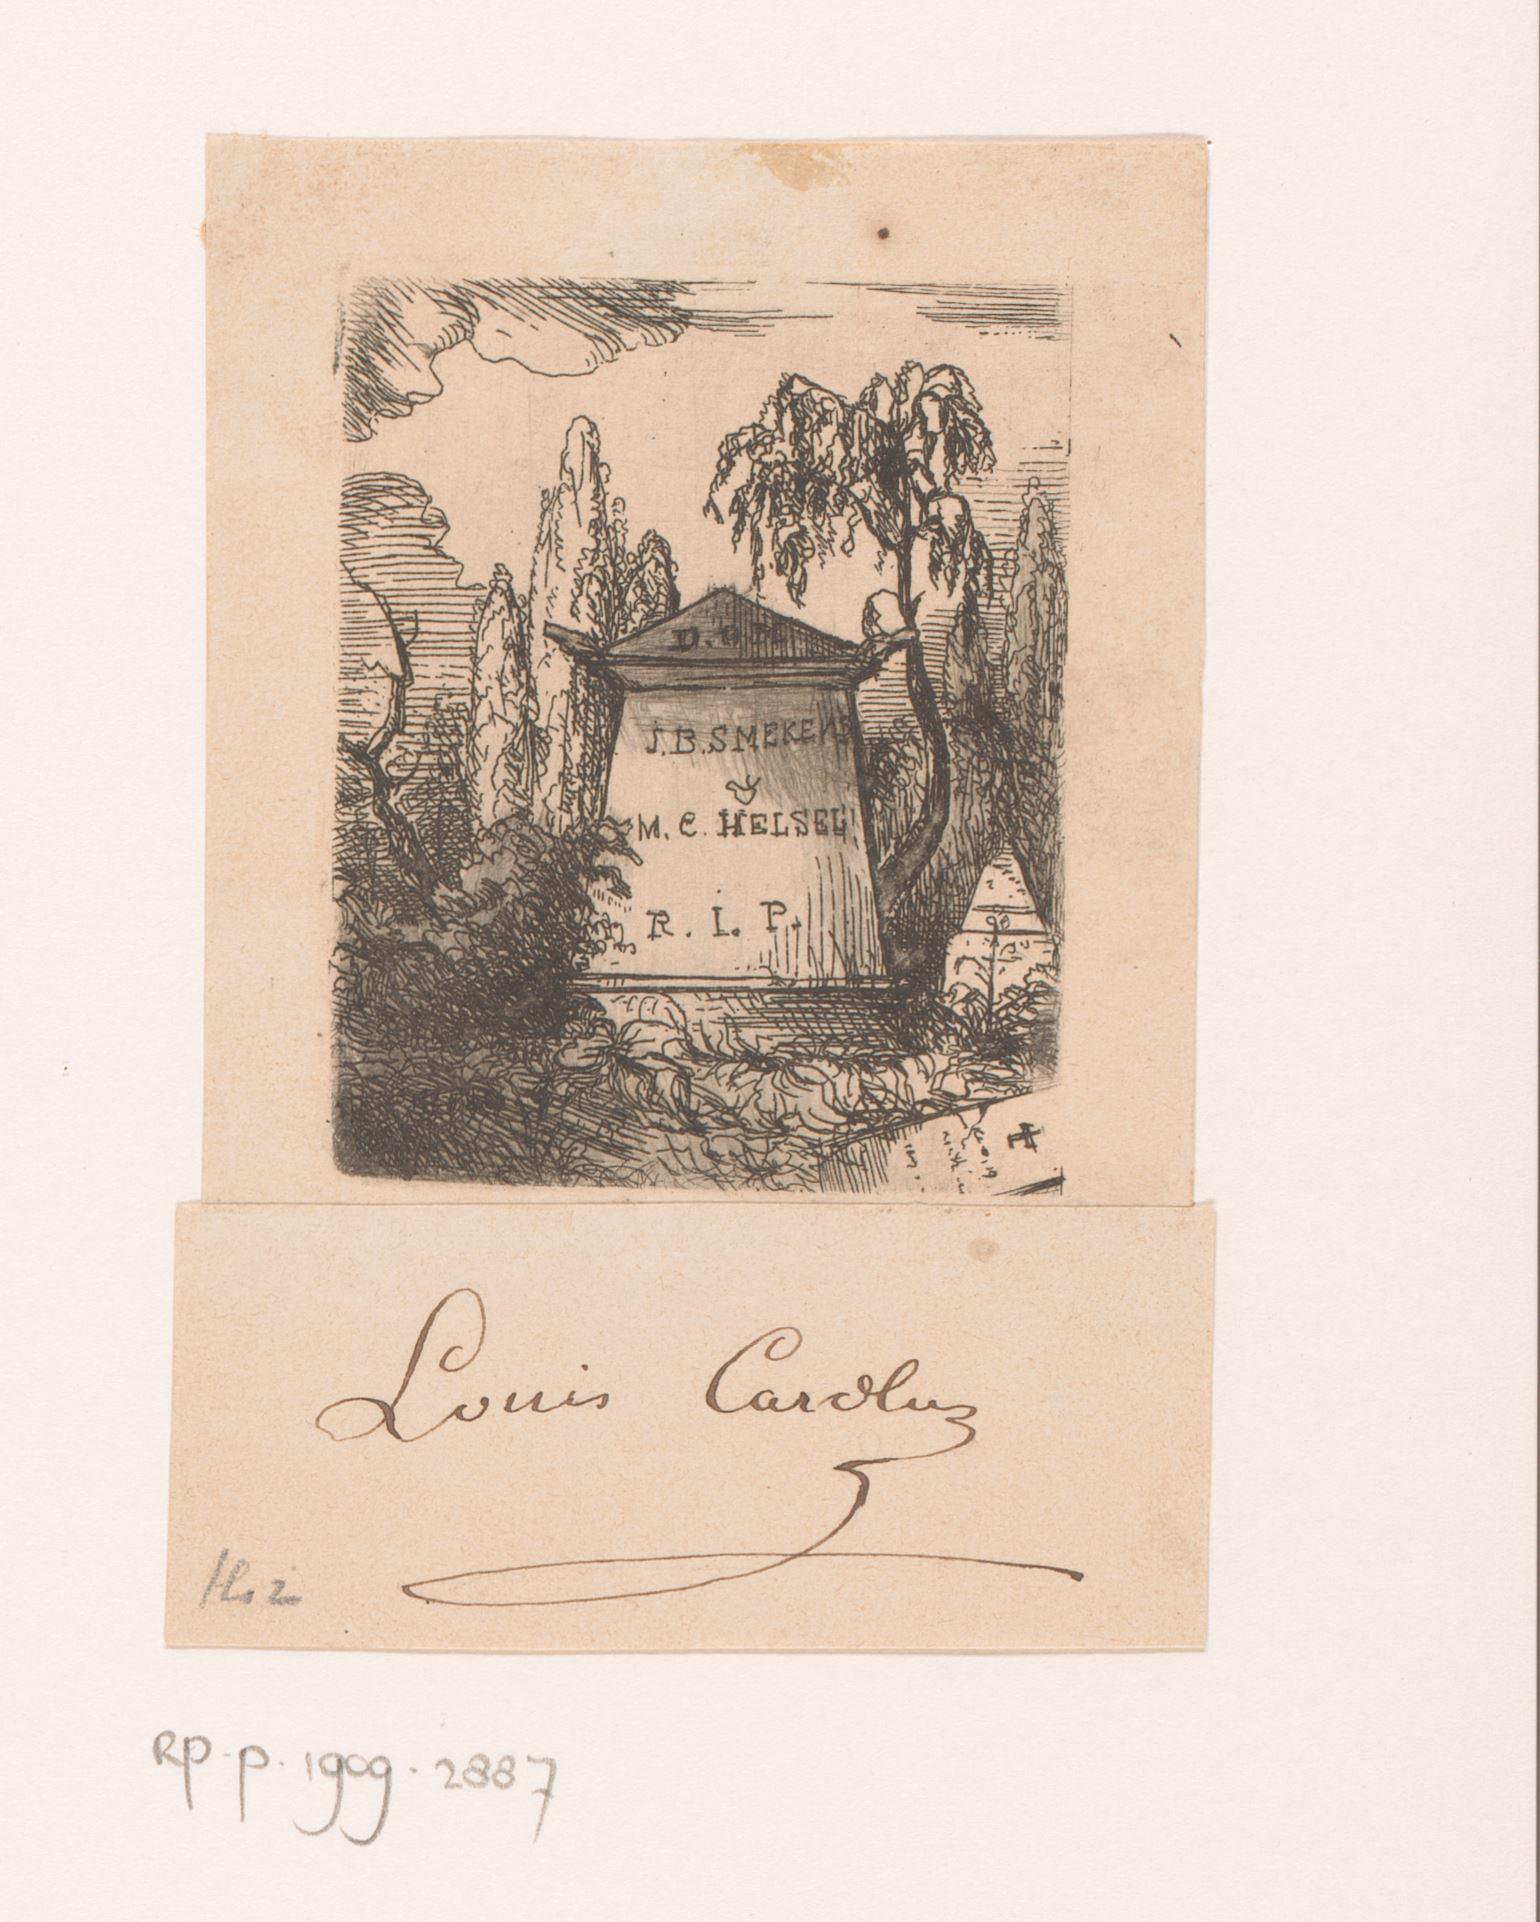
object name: print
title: Grafmonument van J.B. Smekens en M.C. Helsel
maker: louis antoine carolus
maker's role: print maker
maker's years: 1814-1865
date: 1824-1865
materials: paper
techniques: etching, intaglio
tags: grave-building, monumental tomb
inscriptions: collector's mark: Lugt 1485, collector's mark: Lugt 2228